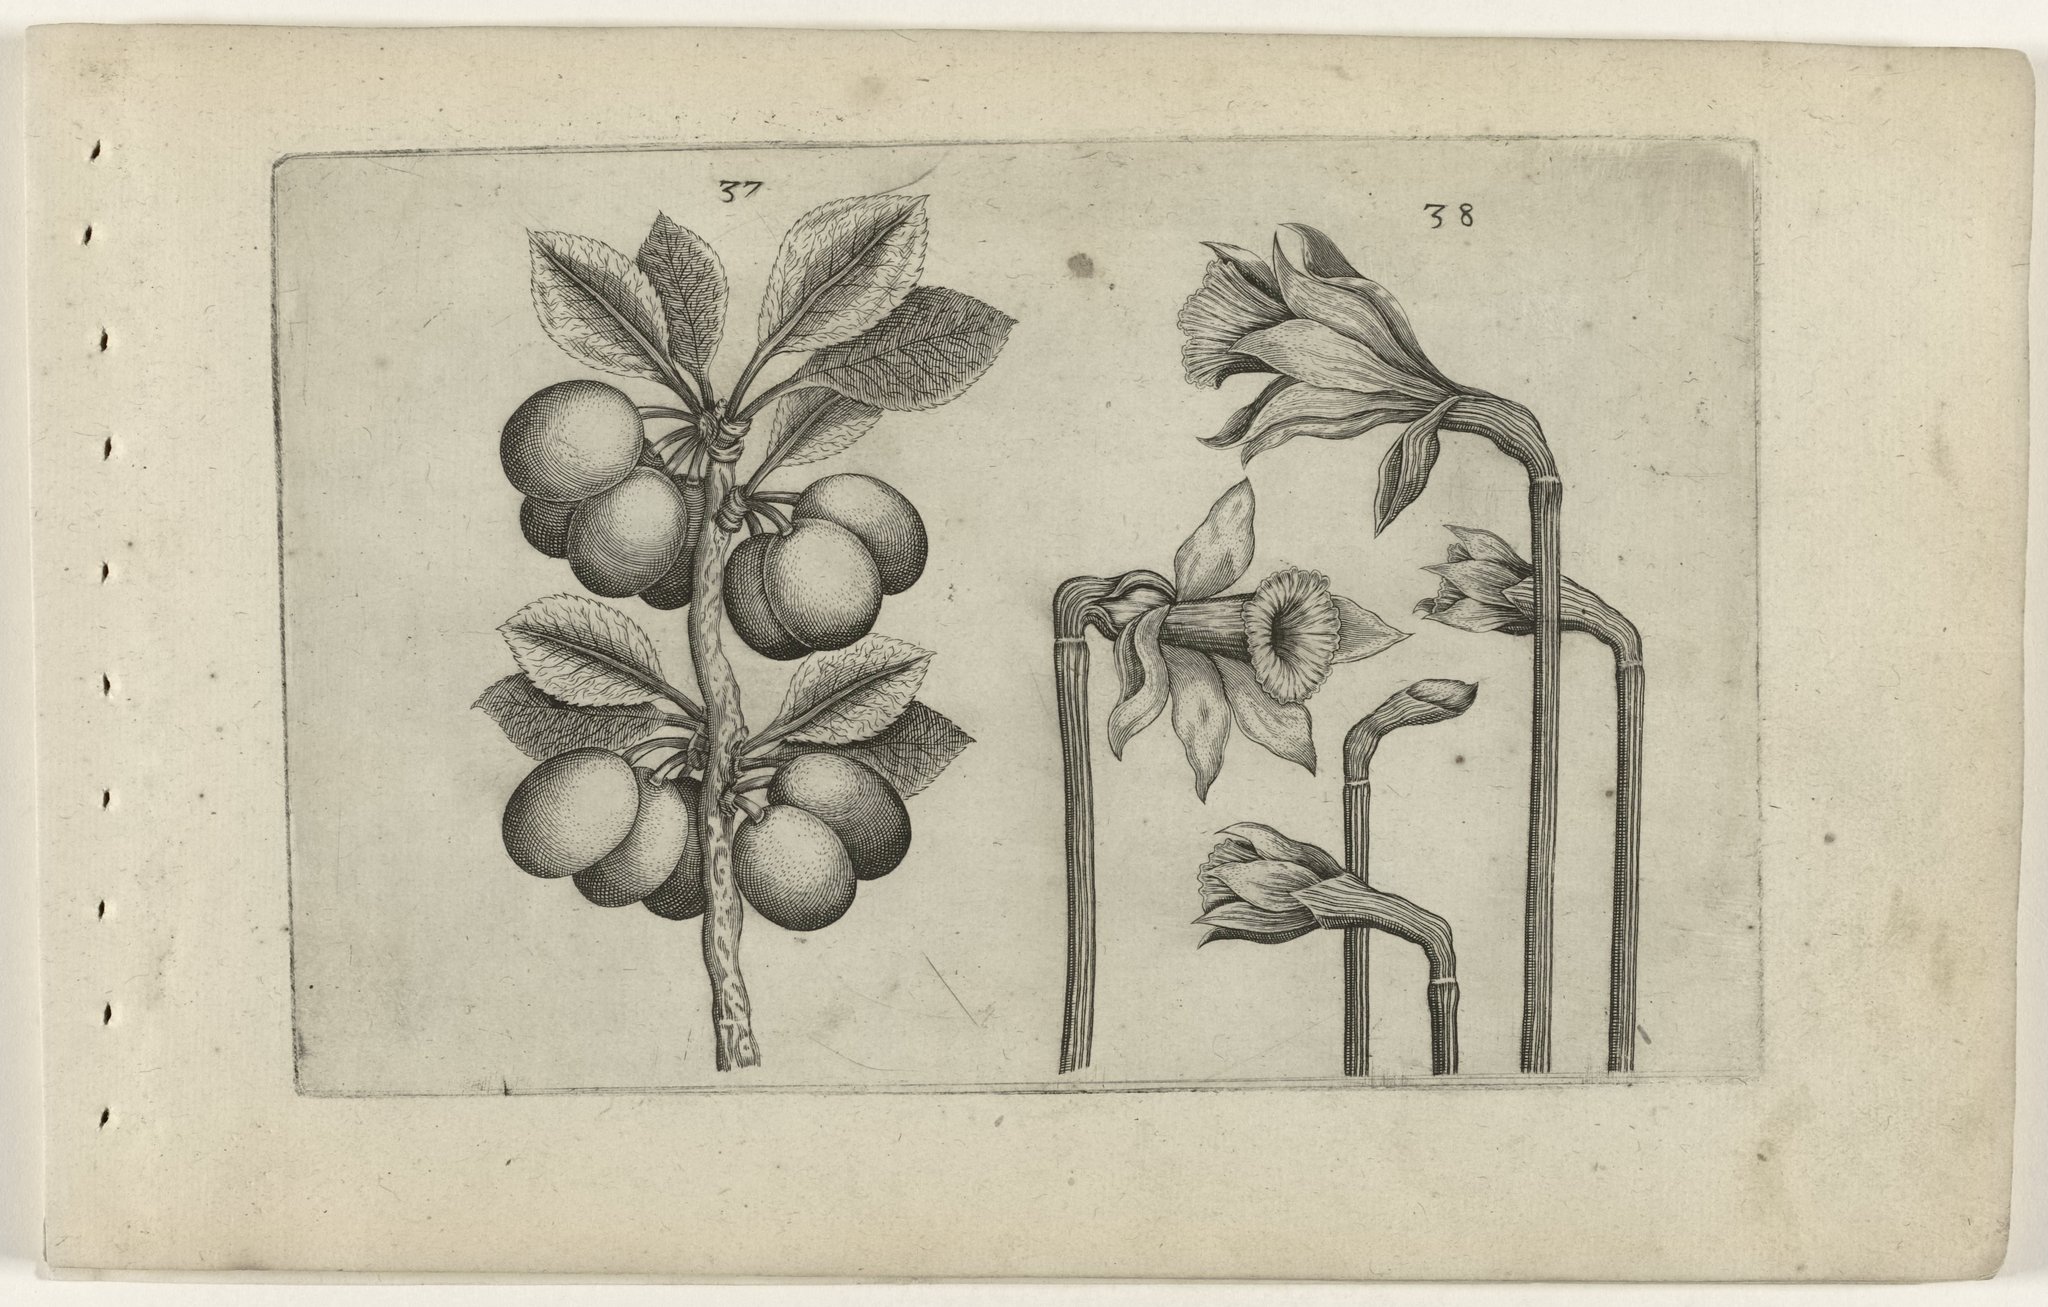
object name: album leaf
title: Zure kers en wilde narcis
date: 1600-1604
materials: paper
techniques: engraving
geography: cologne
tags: fruits: sour cherry, botany, flowers: narcissus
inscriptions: collector's mark: Lugt 2228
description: De prenten RP-P-2012-24-1 t/m 61 waren oorspronkelijk als serie samengebonden. De naaigaten op de bladen zijn nog zichtbaar. Het betreft de reeks getiteld: Cognoscite lilia, bestaande uit een titelprent en 60 gravures met 119 genummerde weergaven van planten, bloemen en vruchten, versierd met rinceaux en kleine voorstellingen van dieren. Het gaat om proefdrukken van deze reeks gravures, voor de opschriften en, deels, voor de nummering. Op enkele prenten zijn de nummers met de hand aangebracht. Op de titelprent ontbreekt nog het adres van Crispijn de Passe en Hans Woutneel. De titel is hoogstwaarschijnlijk gegraveerd door Matthias Quad. Deze werkte voor De Passe in Keulen tot 1604. De reeks moet in dit jaar of daarvoor tot stand zijn gebracht. In ieder geval voor 1608, aangezien de uitgever Hans Woutneel in of voor dat jaar overleed. In ieder geval voor 1608, aangezien de uitgever Hans Woutneel in of voor dat jaar overleed. De gravures worden door Ilja Veldman en Anthony Griffiths beschouwd als eigenhandig werk van Crispijn de Passe I. Een van de prenten uit de reeks ontbreekt (nr 21-22) en is vervangen door een ingekleurde afdruk uit een latere uitgave (RP-P-2012-24-61), die onder de titel Altera Pars is opgenomen in de Hortus Floridus, uitgegeven door Crispijn de Passe I en die verder bestaat uit platen van Crispijn de Passe II. De prenten afkomstig uit deze uitgave zijn op de verso voorzien van tekst in boekdruk. De vervangende prent maakte geen deel uit van de gebonden serie aangezien dit blad als enige geen naaigaten heeft. Een deel van de planten, bloemen en vruchten in de Cognoscite lilia gaat terug of is gebaseerd op een reeks aquarellen van Jacques LeMoyne uit circa 1580 en uit 1585, nu in het Victoria and Albert Museum en de British Museum (zie P. Hulton, Jacques LeMoyne, Londen 1977, dl 1, p. 156-162 en p. 165-173).